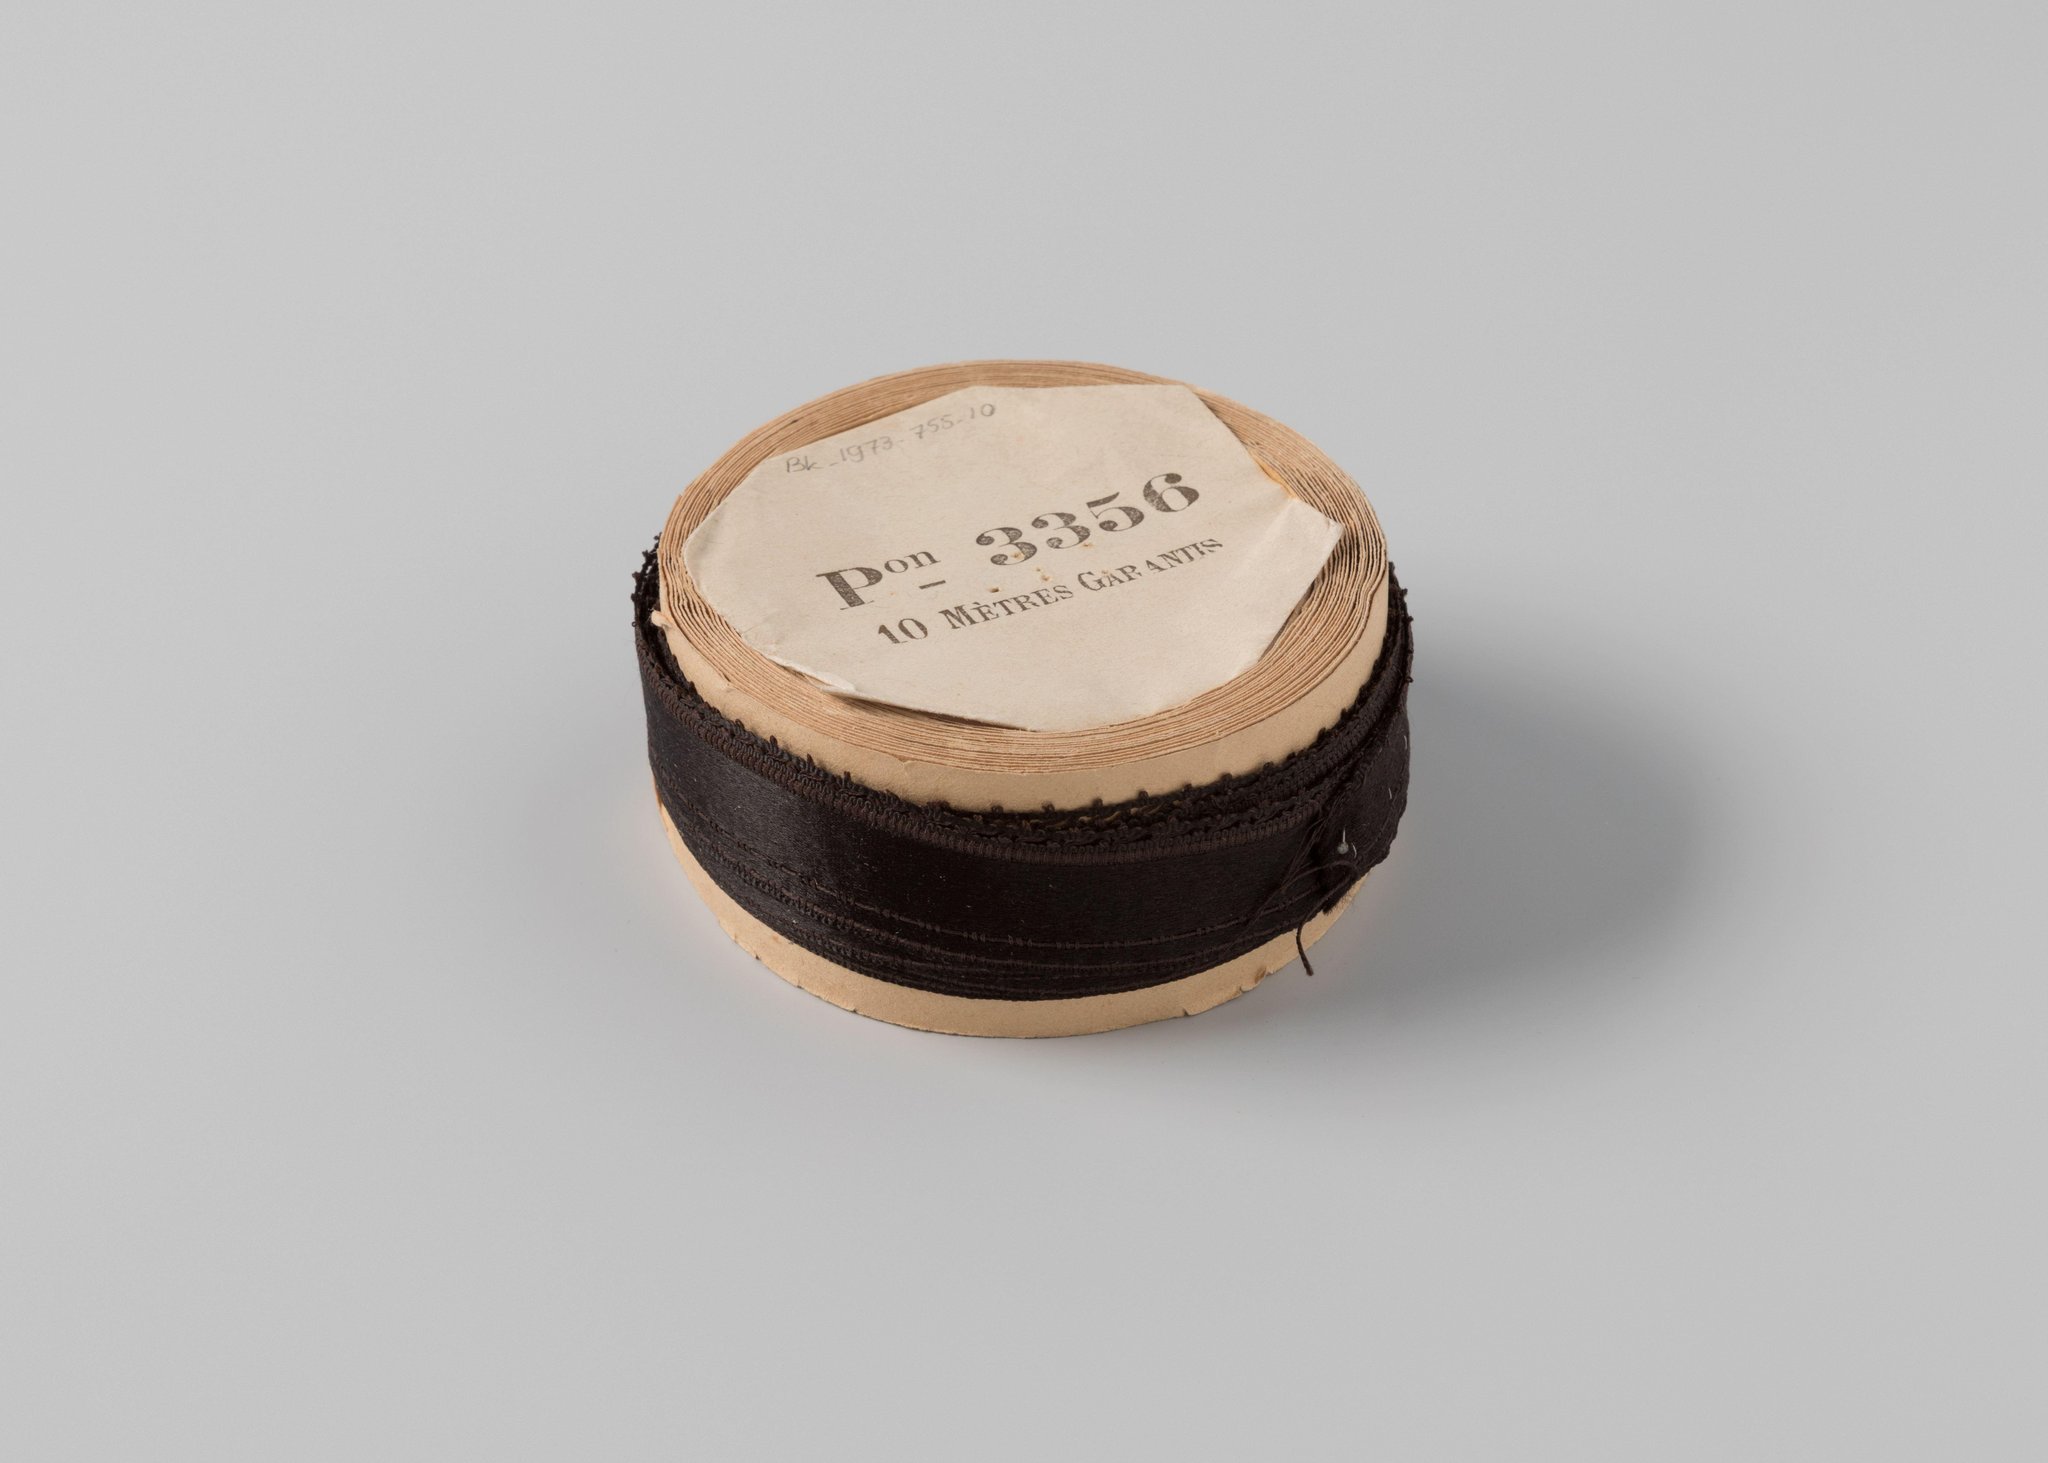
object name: braid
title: Lint op rol, zwart satijn met één zijde voorzien van picots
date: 1890-1935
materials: cardboard, paper, textile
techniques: weave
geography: nijmegen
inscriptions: number: ‘Pon 3356’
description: Lint op rol, zwart satijn met één zijde voorzien van picots.